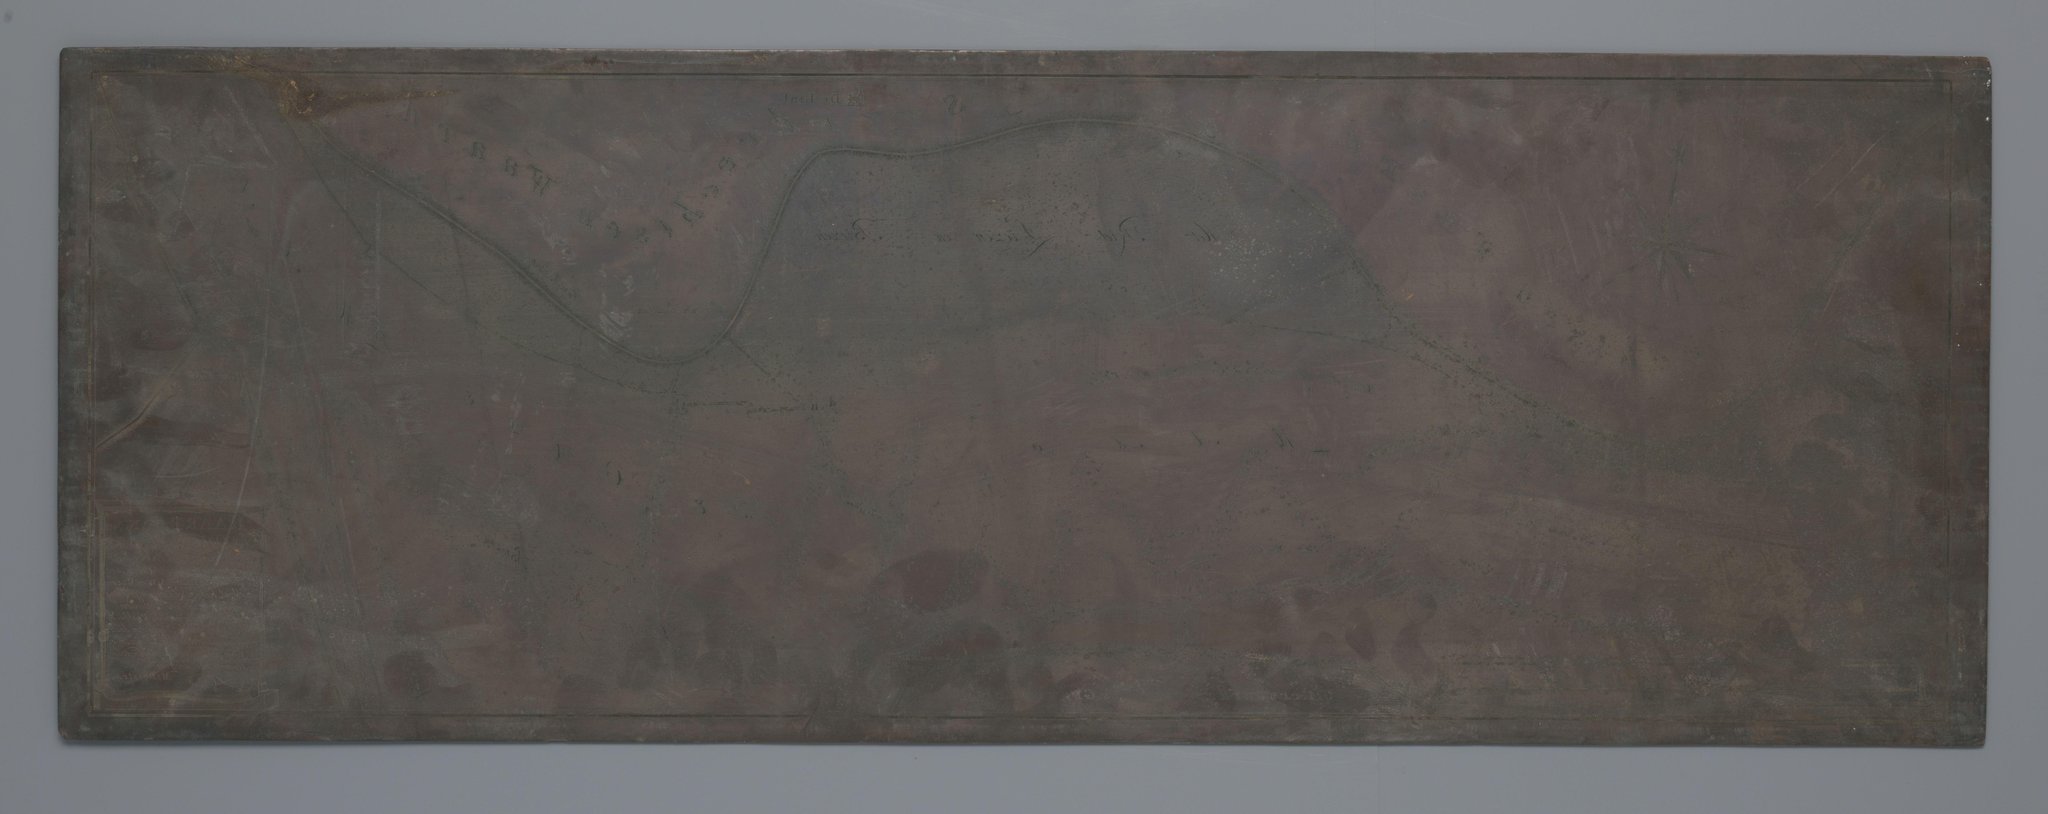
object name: copper plate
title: Kaart van de Oude Maas omtrent de Lint en Krabbe (...)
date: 1771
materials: copper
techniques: engraving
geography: the hague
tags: oude maas